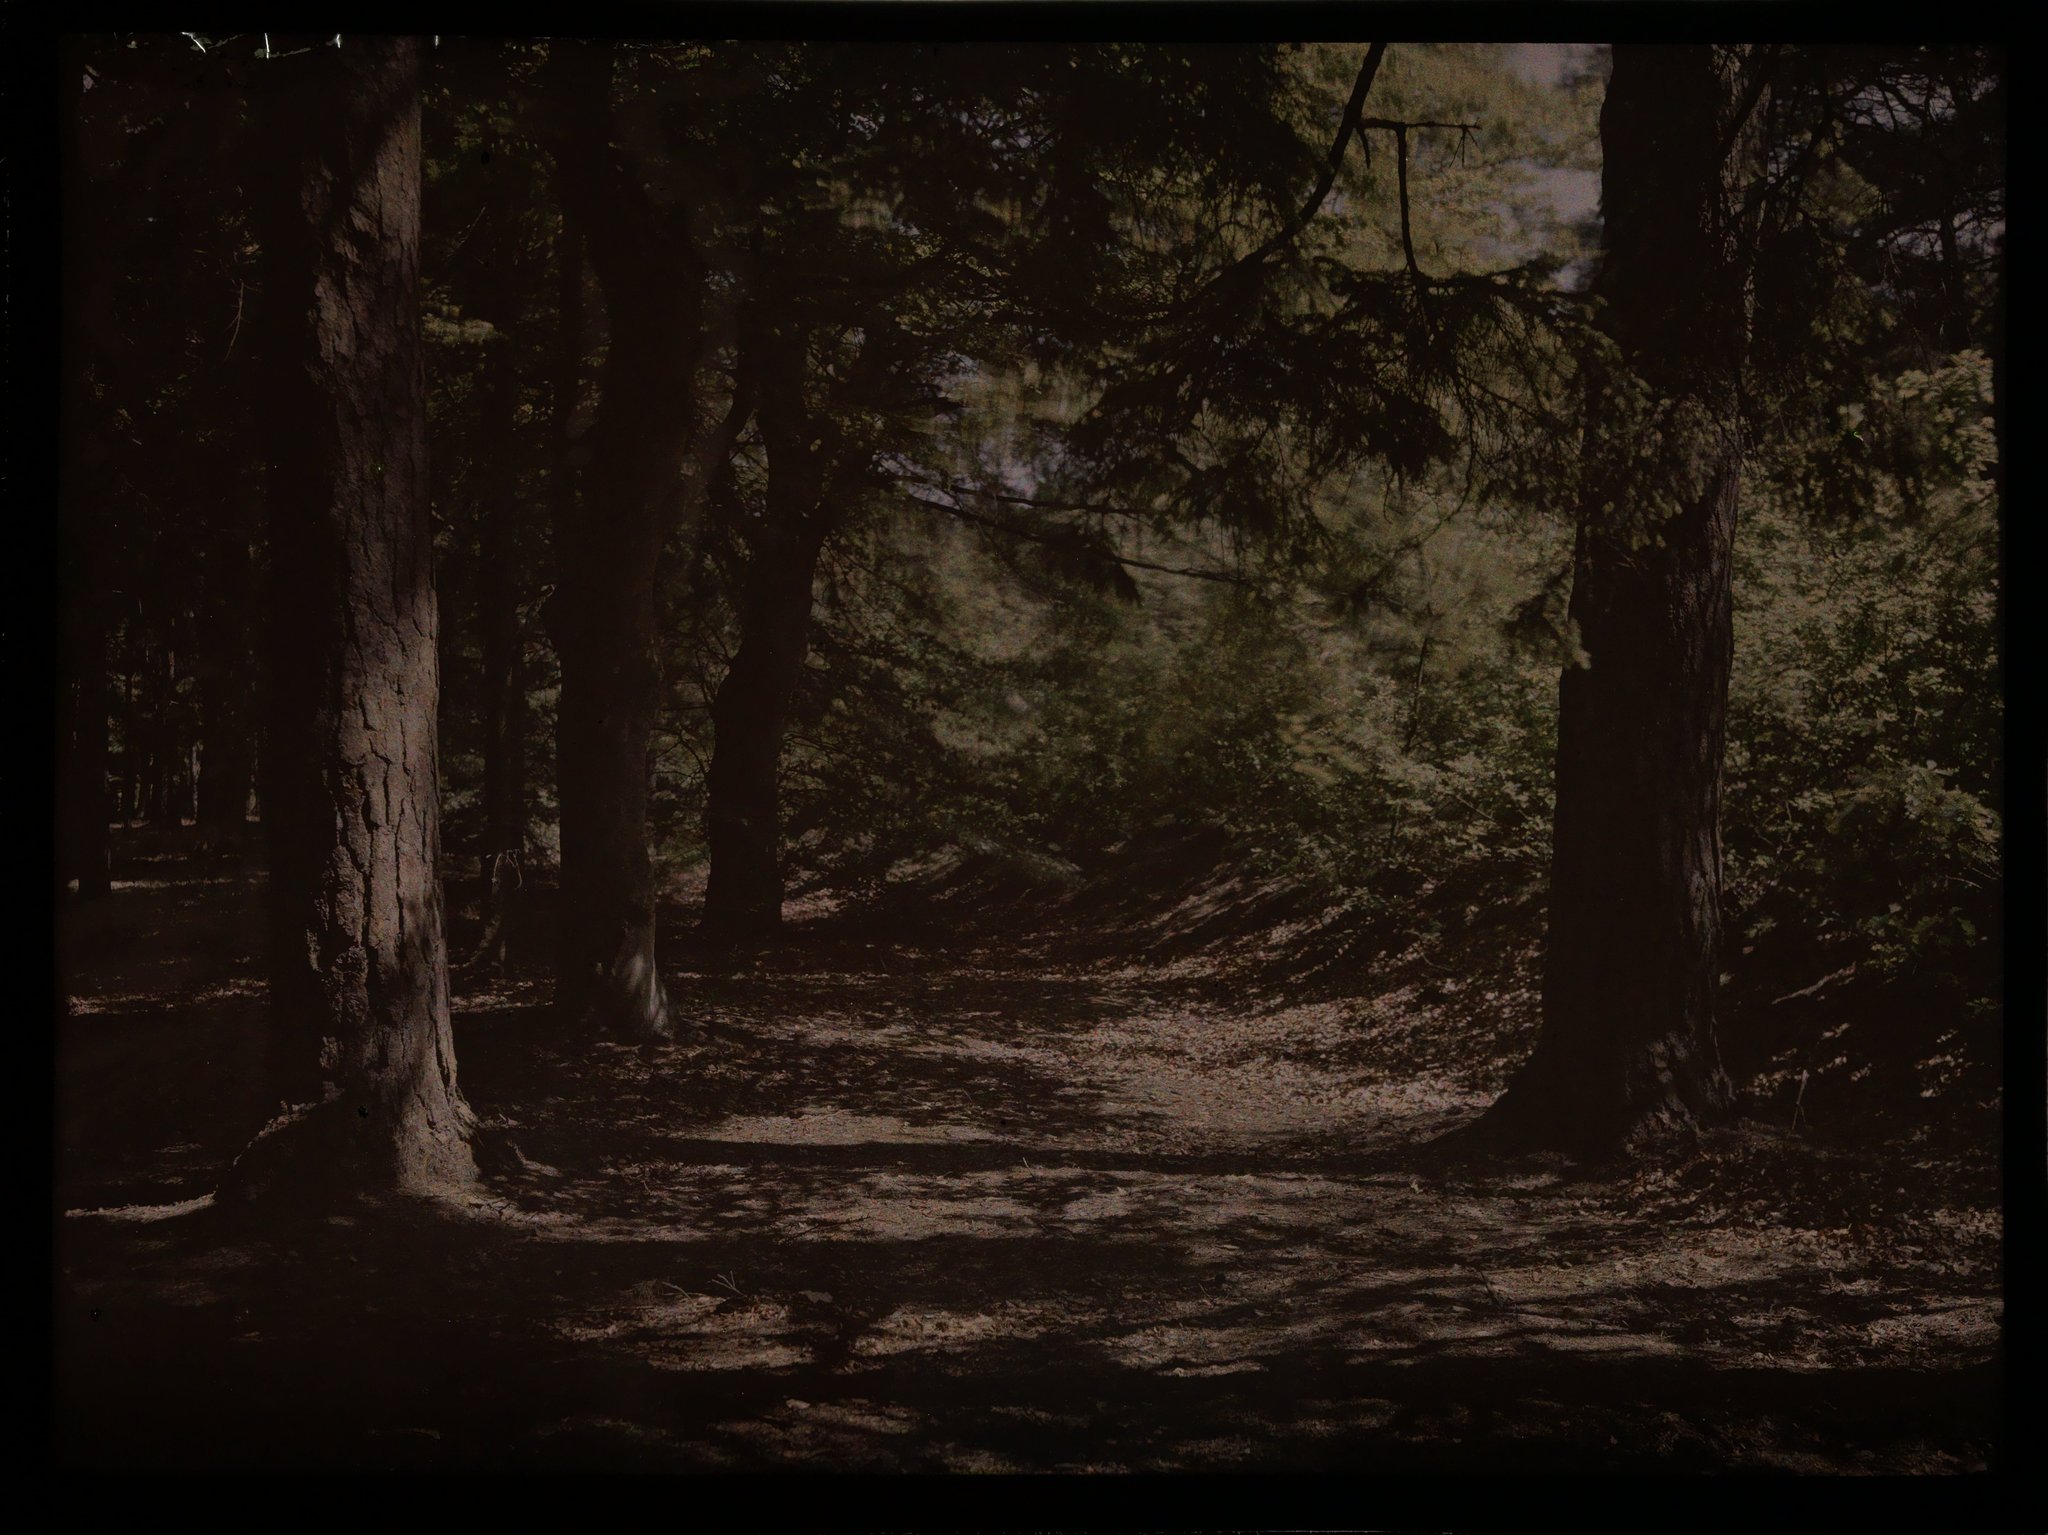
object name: photograph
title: Boslandschap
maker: Anonymous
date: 1907-1935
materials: glass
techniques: autochrome process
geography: netherlands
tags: forest, wood, netherlands